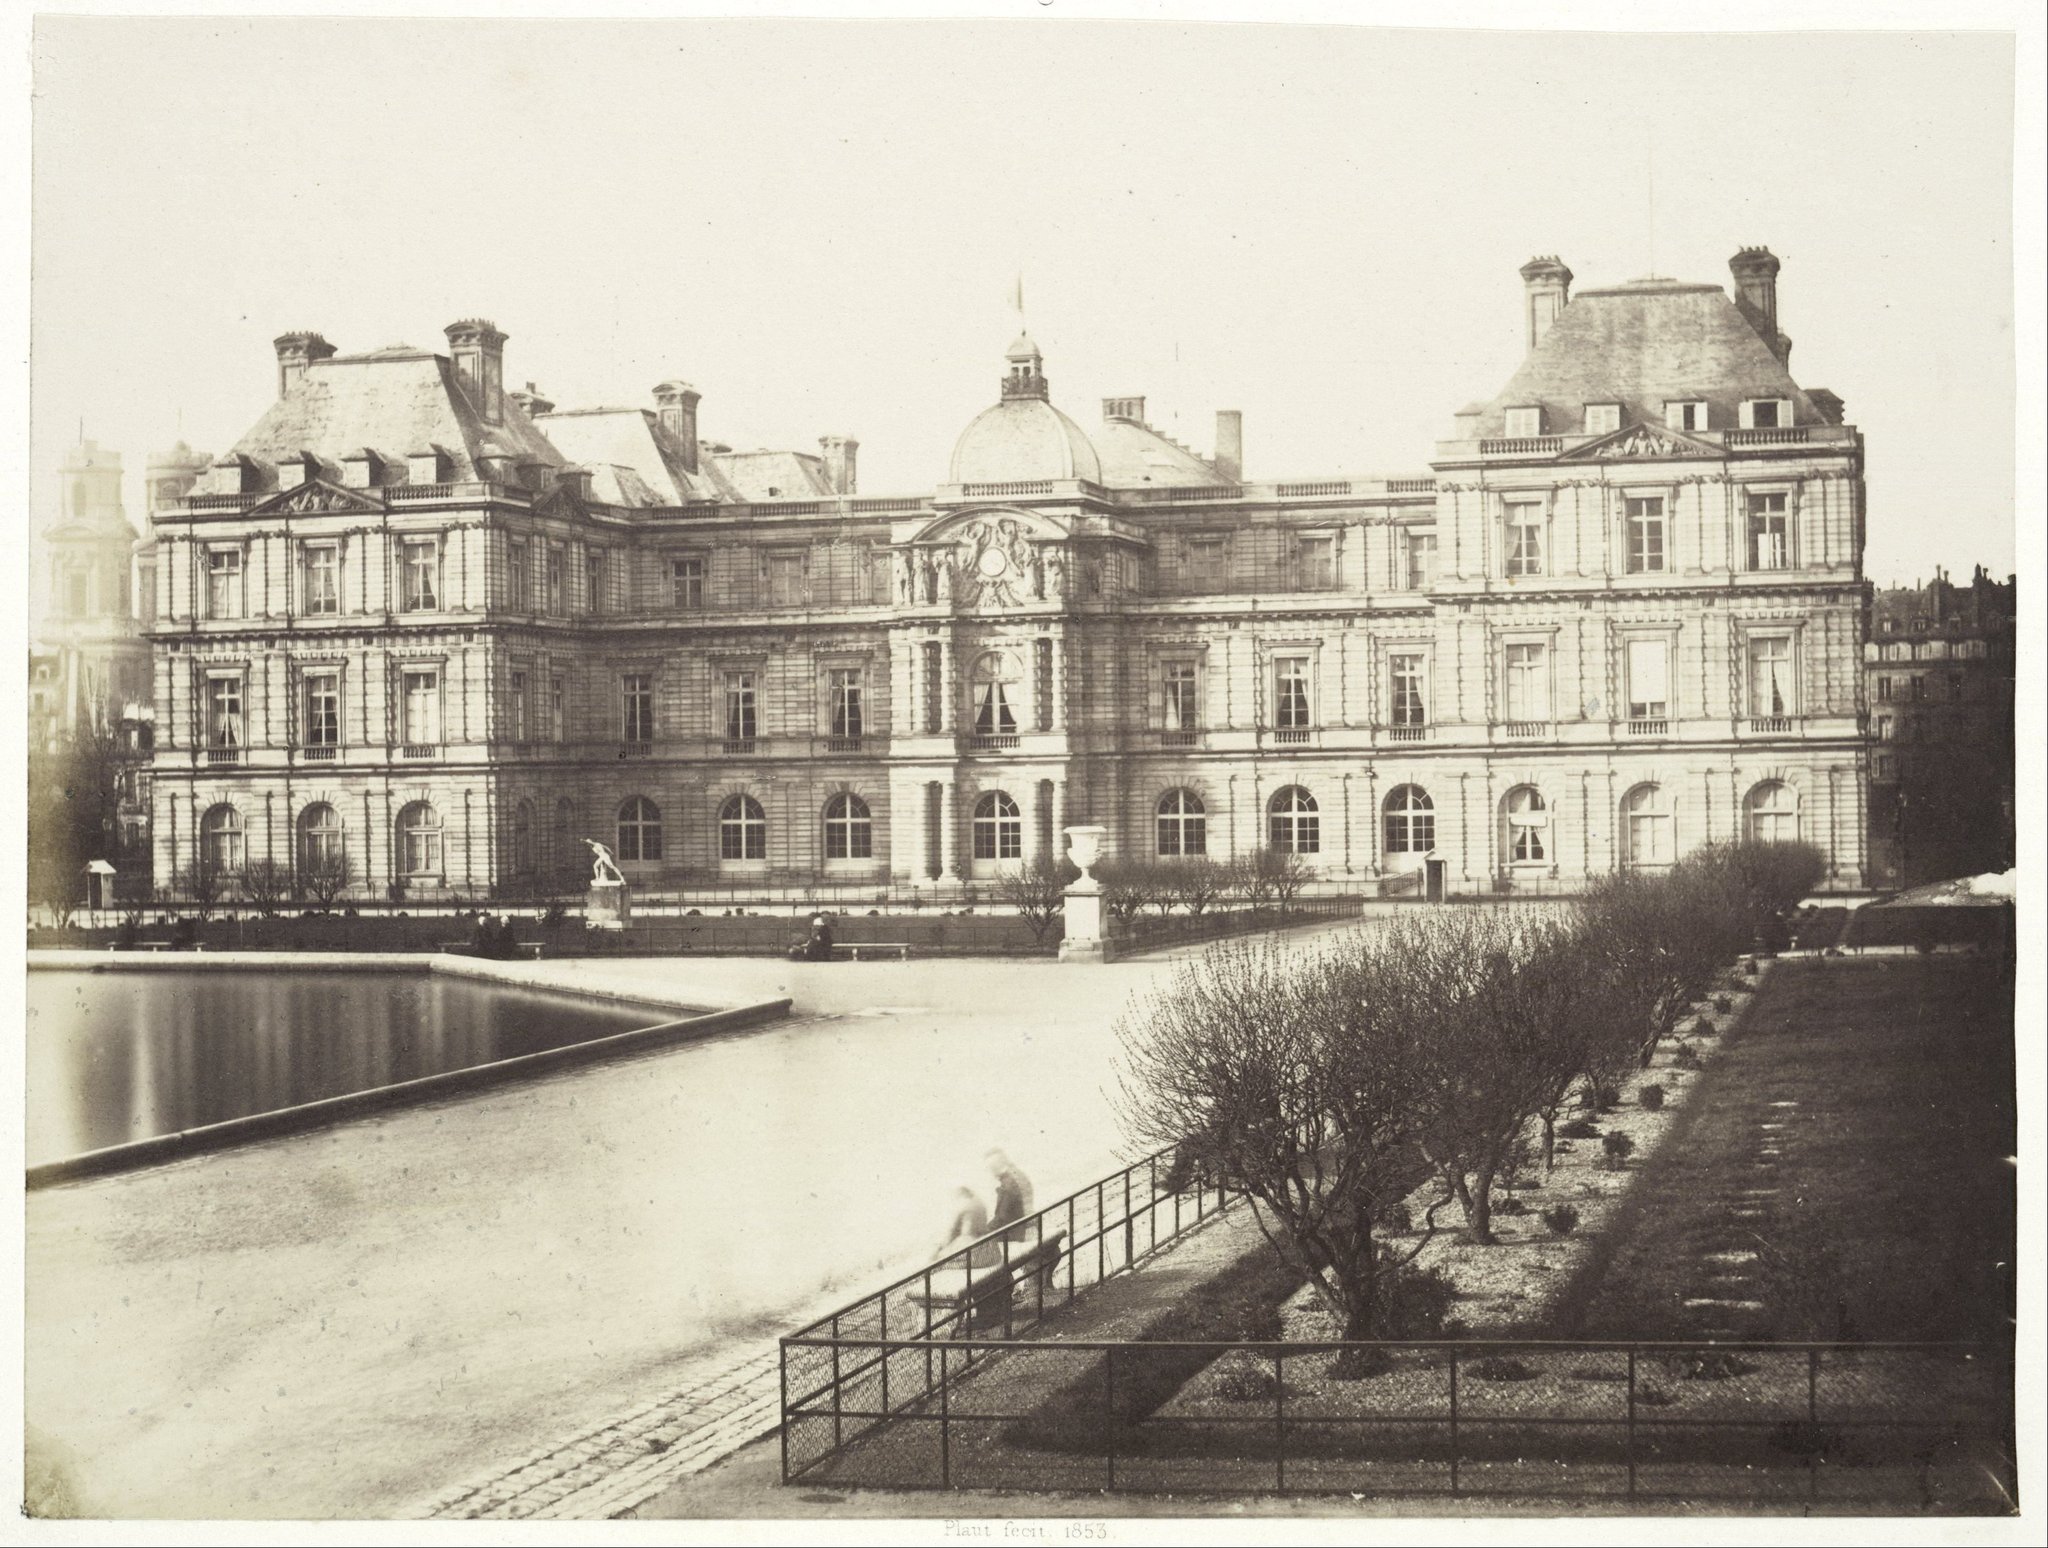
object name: photograph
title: Palais du Luxembourg. Côté du Jardin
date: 1853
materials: cardboard, paper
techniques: salted paper print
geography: paris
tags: palace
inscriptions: inscription: ‘Paris Photographie Pl. 26./ Plaut fecit. 1853/ PALAIS DU LUXEMBOURG/ Côté du Jardin/ Publié par GOUPIL & Cie Editeurs,/ Paris, London, Berlin, New York./ Imp. Photographique de H. de Fonteny,/ Rue St. Nicolas d'Antin, 72, Paris.’